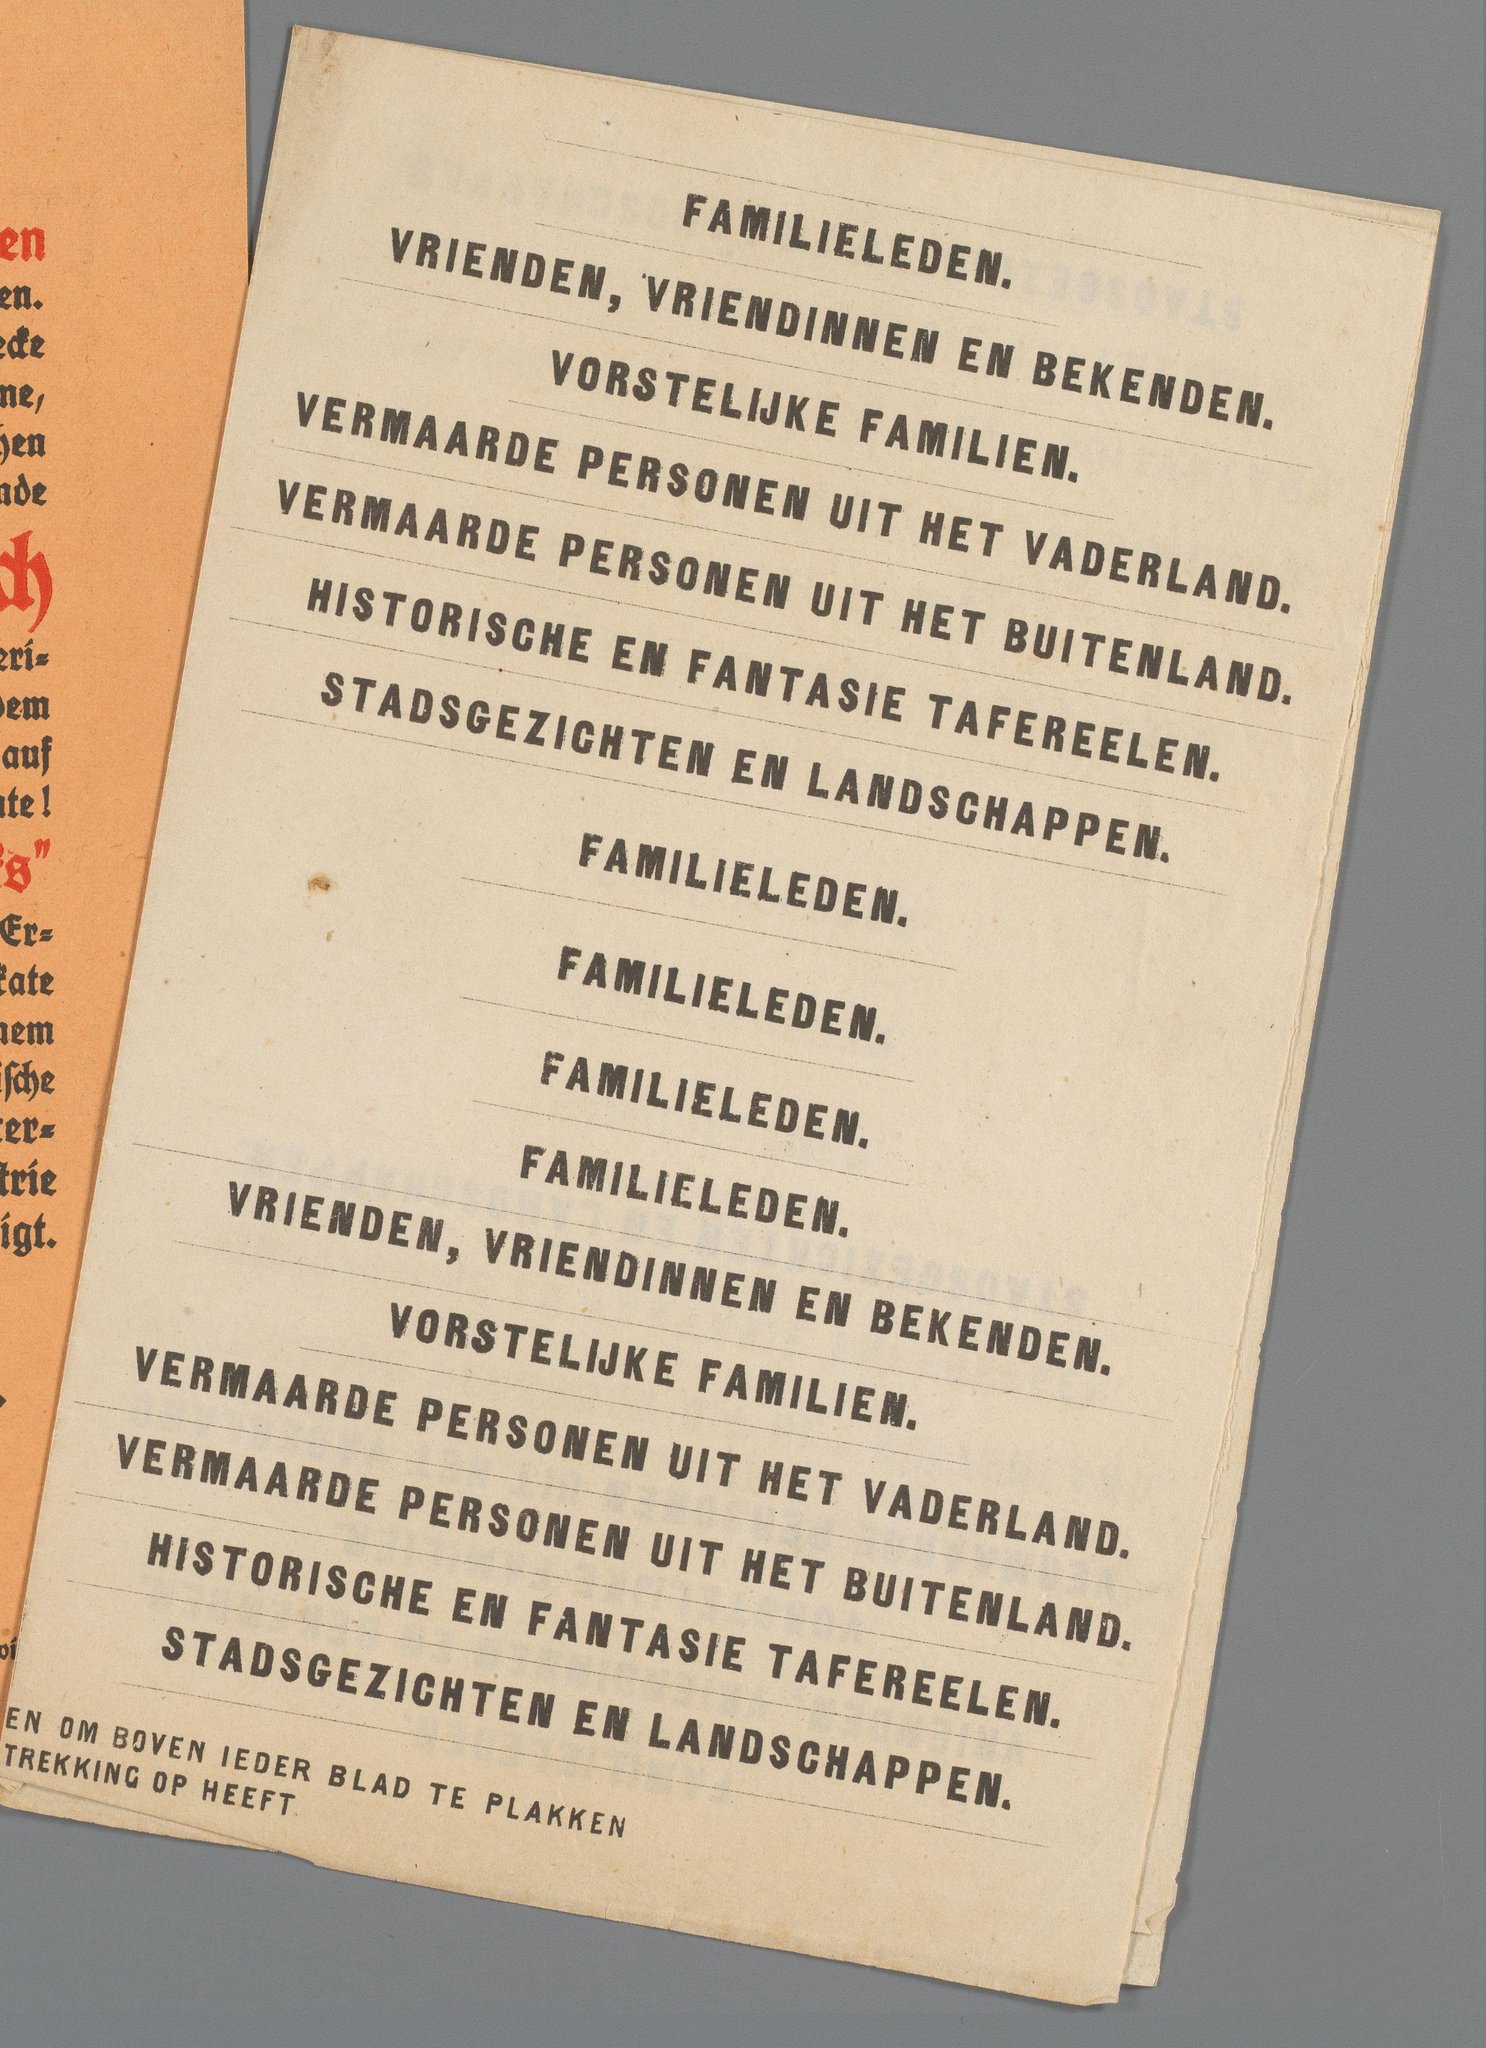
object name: label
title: Tekststroken met opschriften voor albumbladen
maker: Anonymous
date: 1900-1940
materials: paper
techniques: letterpress printing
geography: netherlands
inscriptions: inscription: ‘Deze opschriften dienen om boven ieder blad te plakken/ daar waar dezelve betrekking op heeft’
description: Blad met viermaal dezelfde tekst. Van een van de vier zijn meerdere stroken afgeknipt.